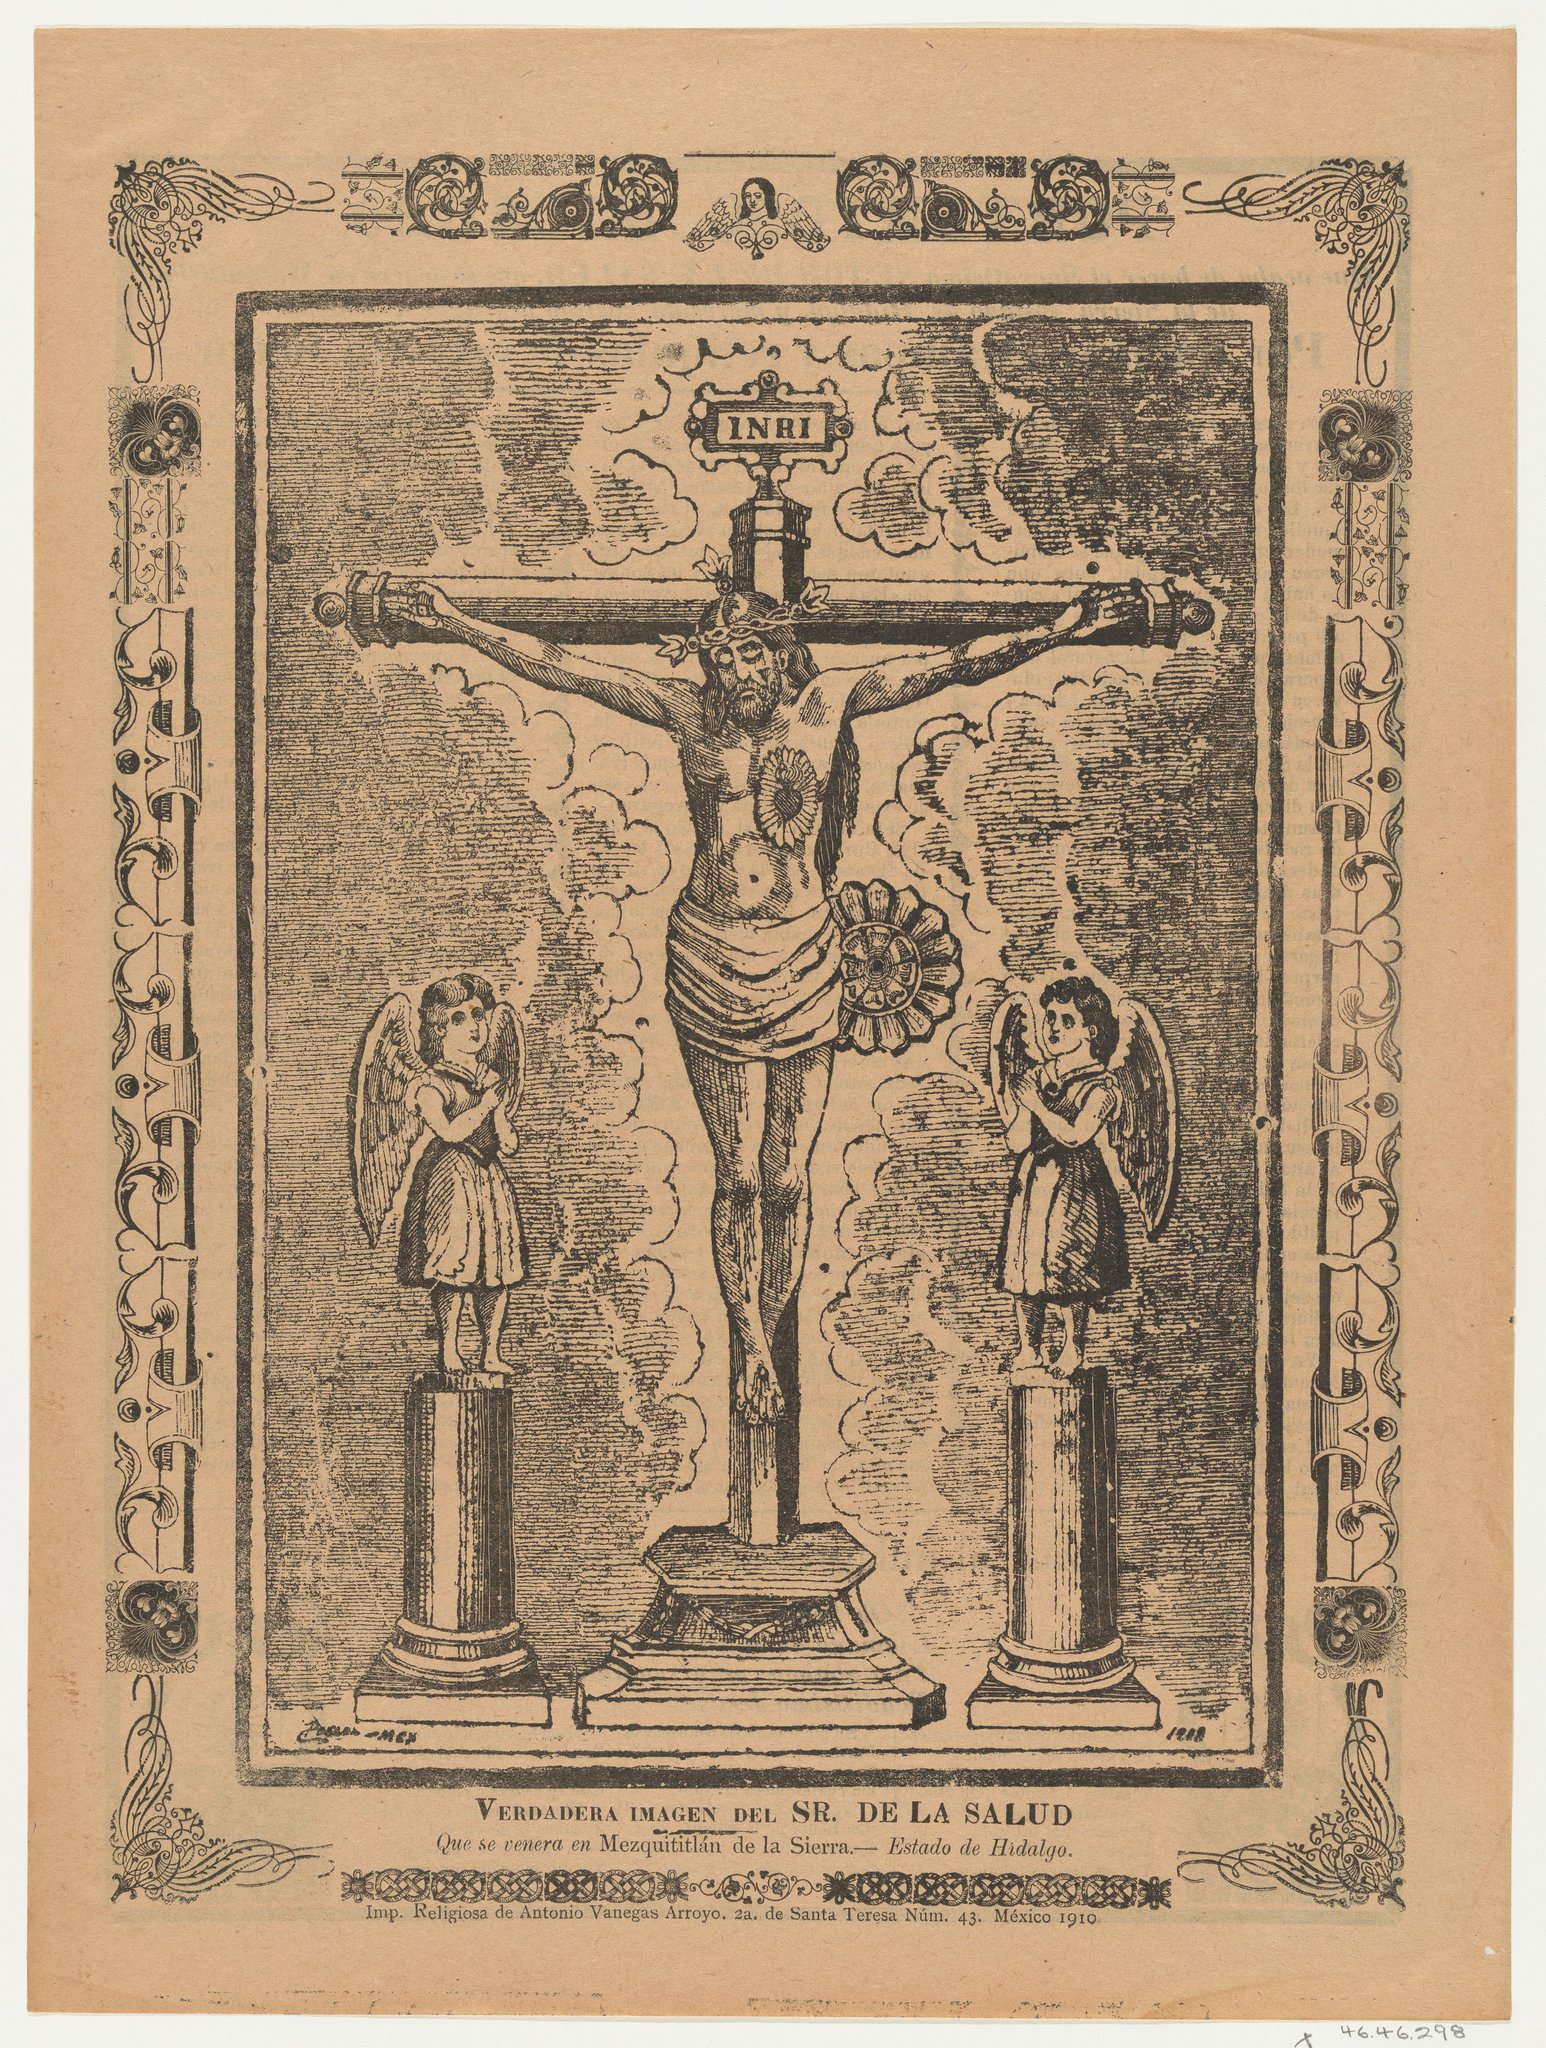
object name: print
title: Broadsheet with Christ in the cross flanked by two angels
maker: Anonymous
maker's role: artist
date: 1910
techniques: letterpress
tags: angels,christ,cross